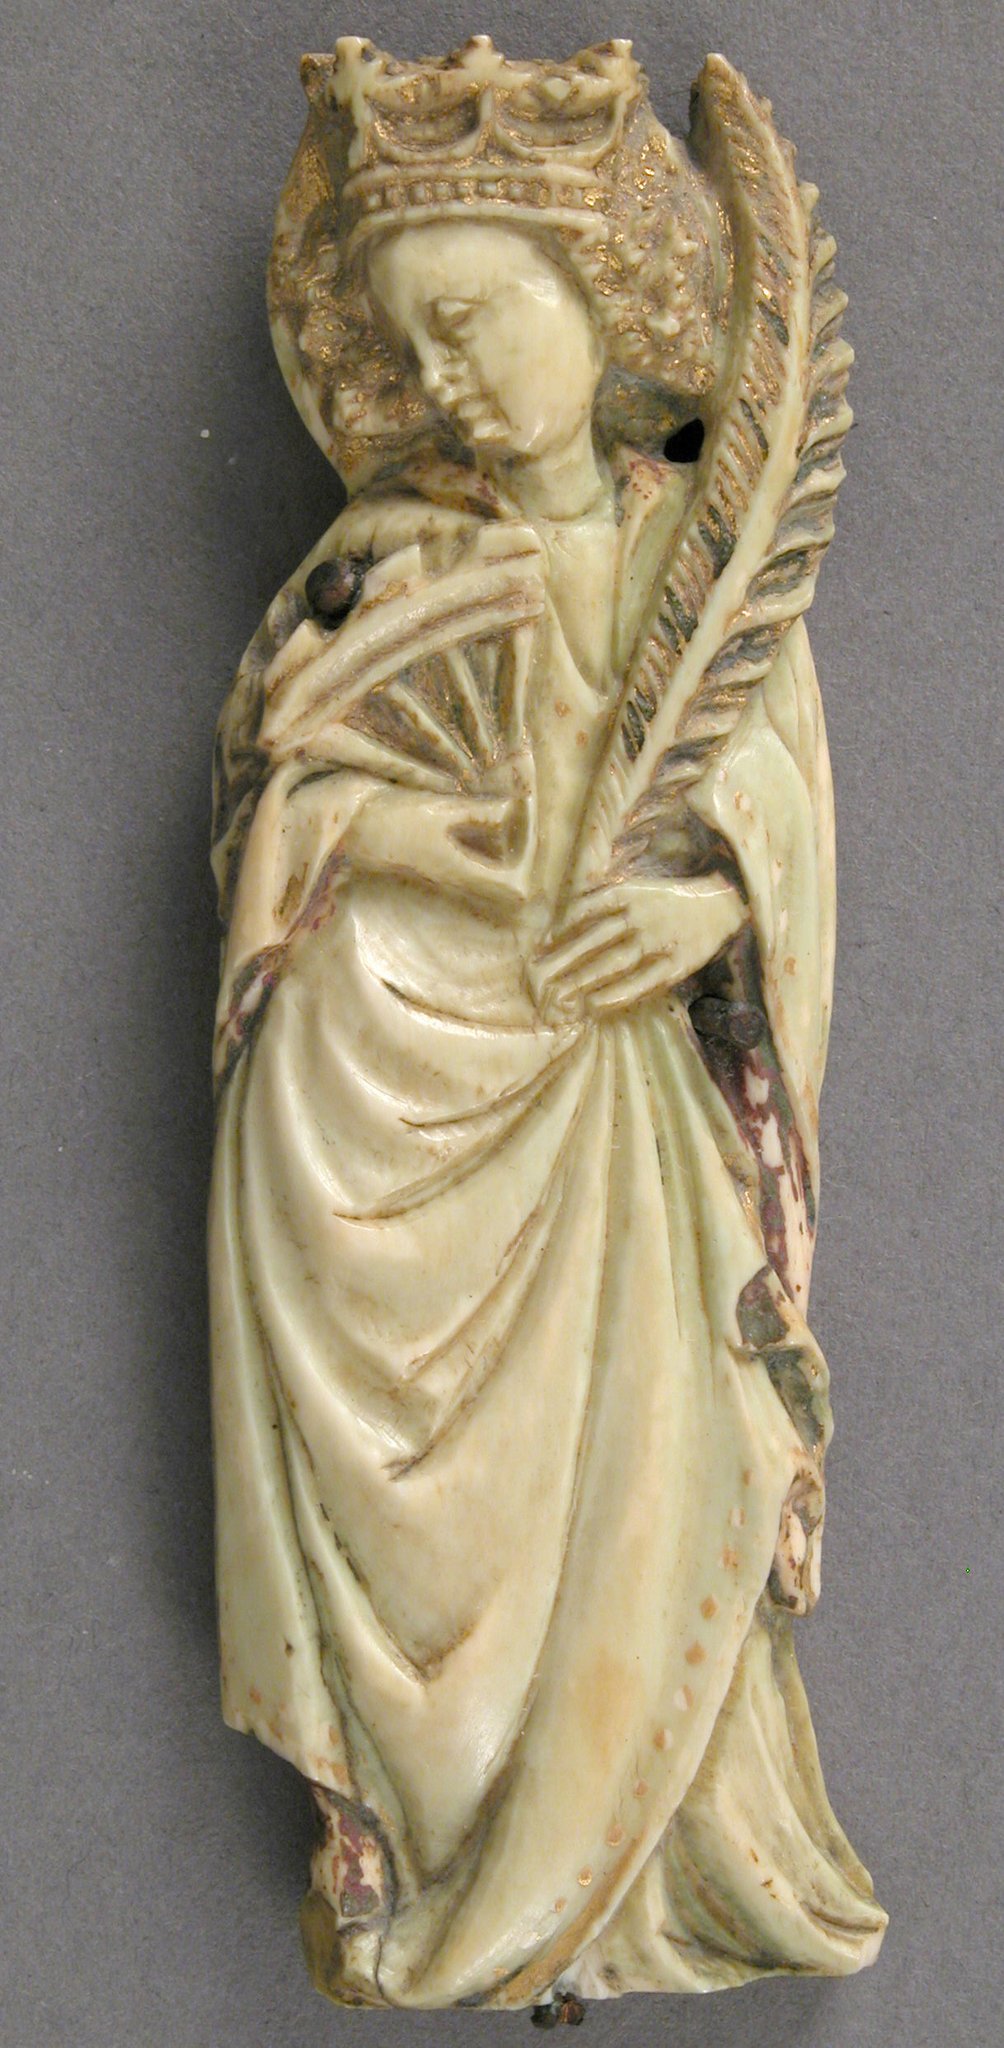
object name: plaque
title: Plaque with Saint Catherine of Alexandria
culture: french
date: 1400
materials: ivory, paint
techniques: gilding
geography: france